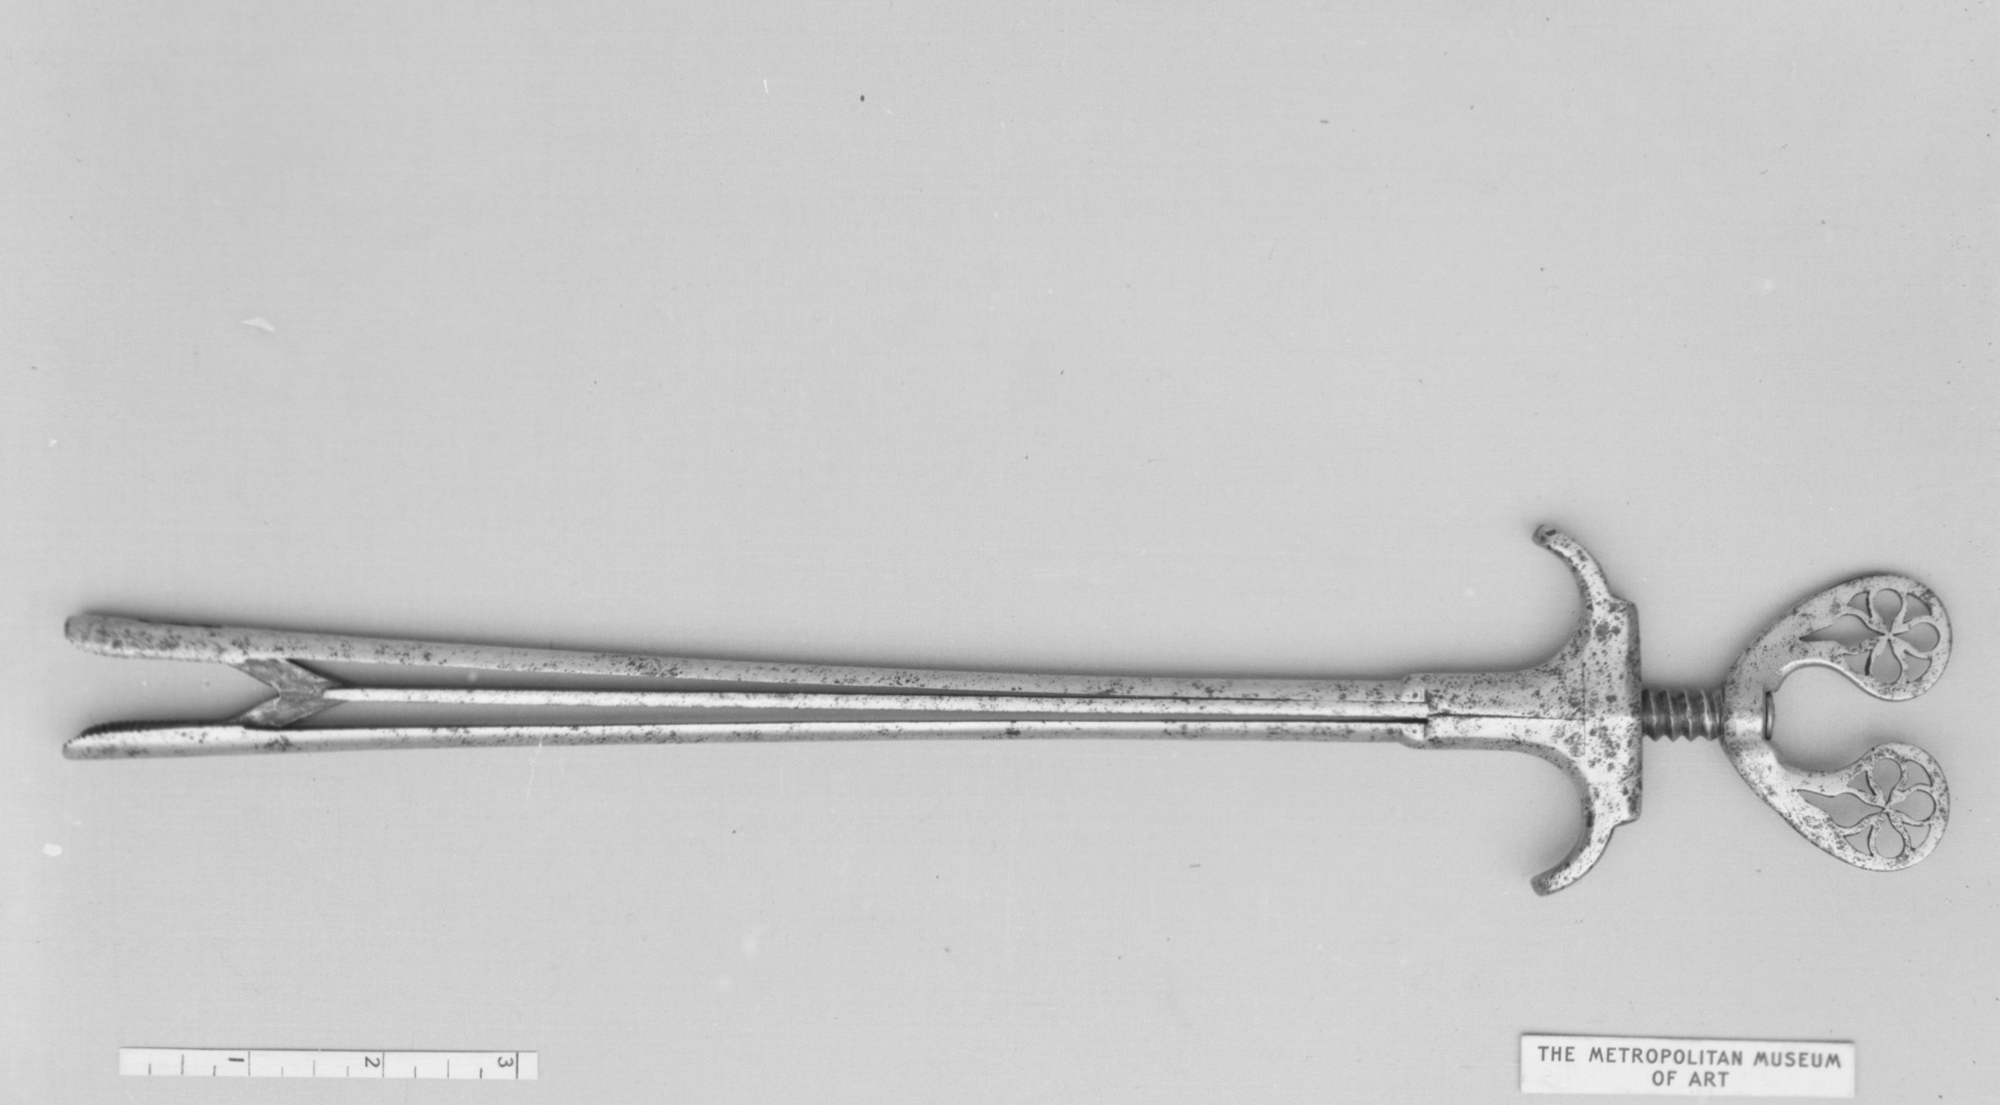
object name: bullet forceps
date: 1601-1800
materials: steel